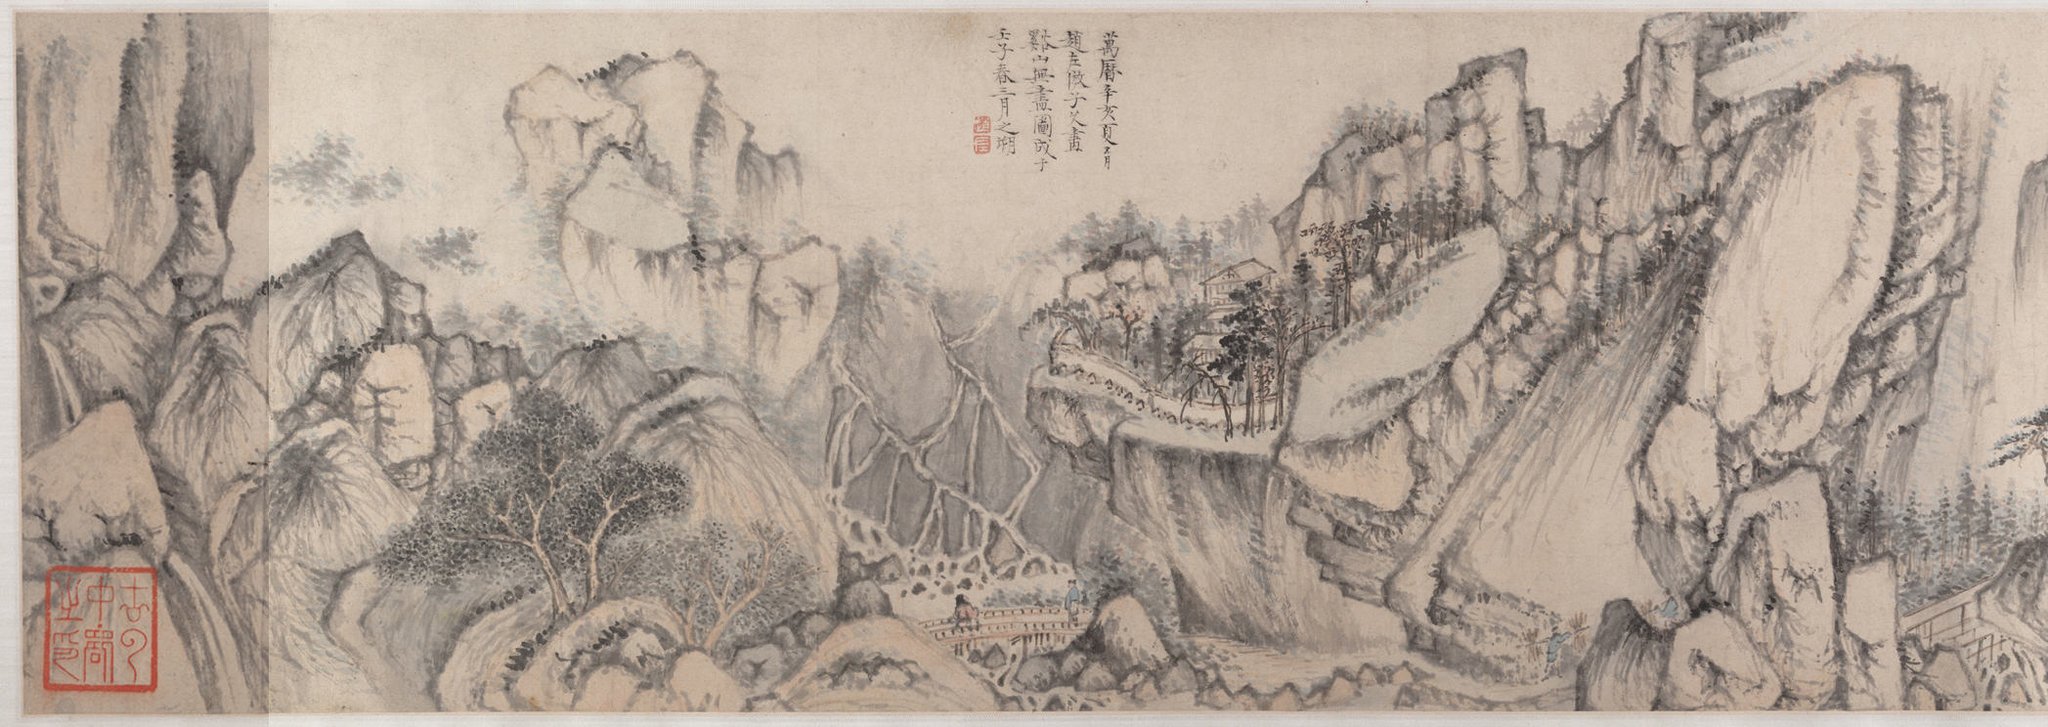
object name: handscroll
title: Streams and Mountains without End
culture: chinese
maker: zhao zuo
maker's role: artist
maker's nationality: chinese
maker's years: 1560-1630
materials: ink, paper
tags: mountains